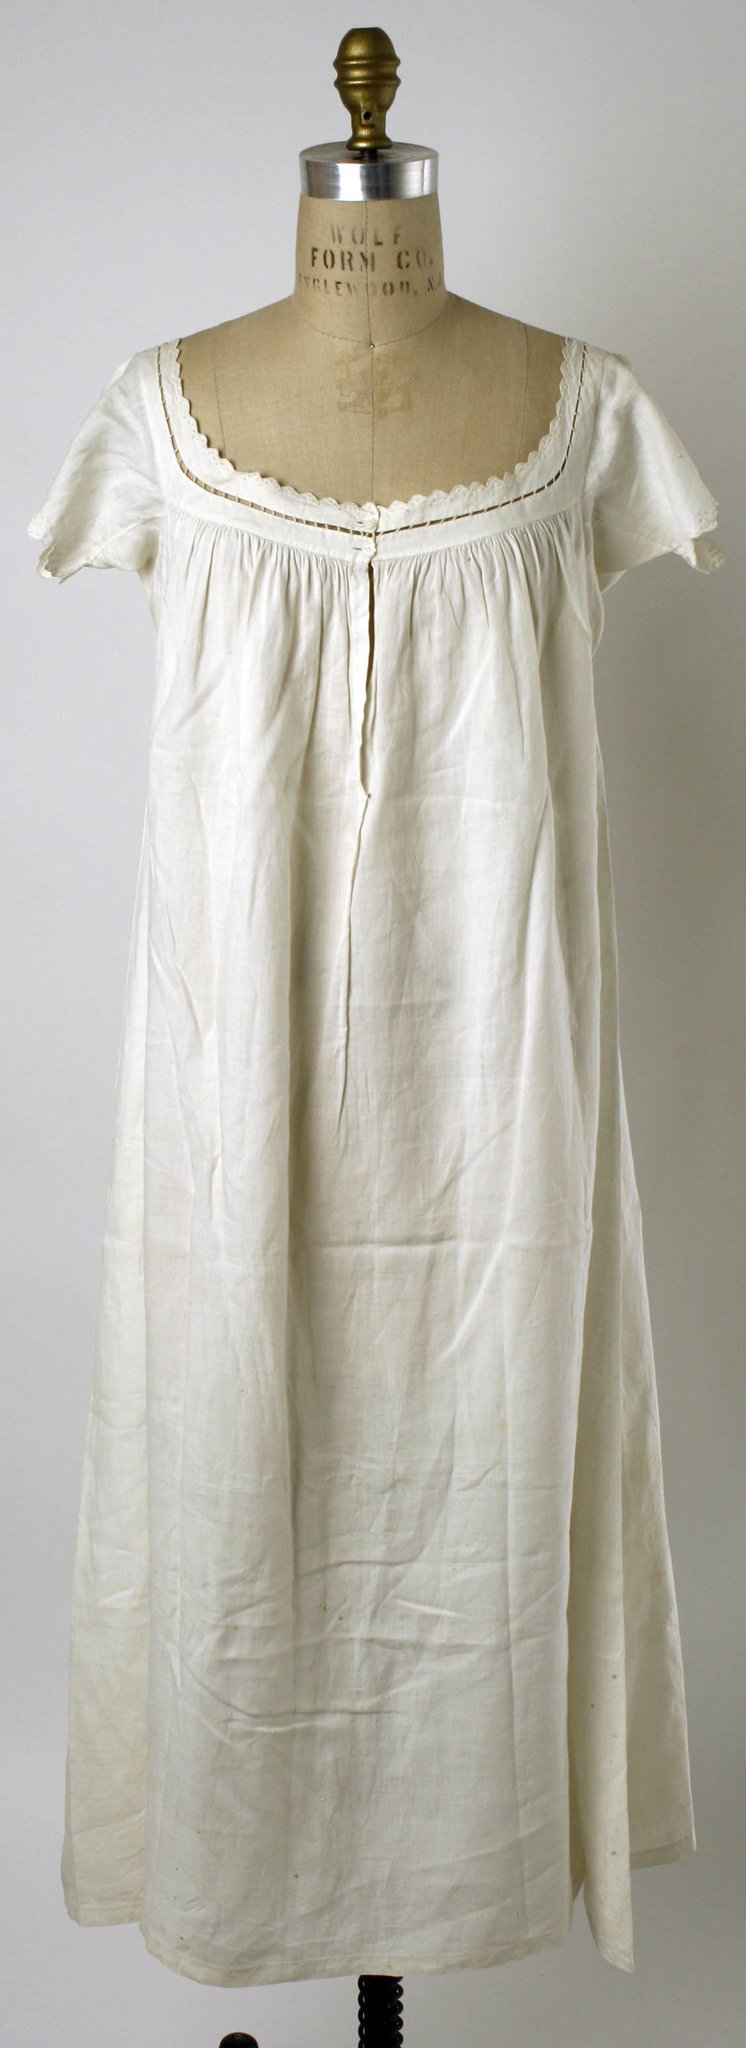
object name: chemise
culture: american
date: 1840-1859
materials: linen